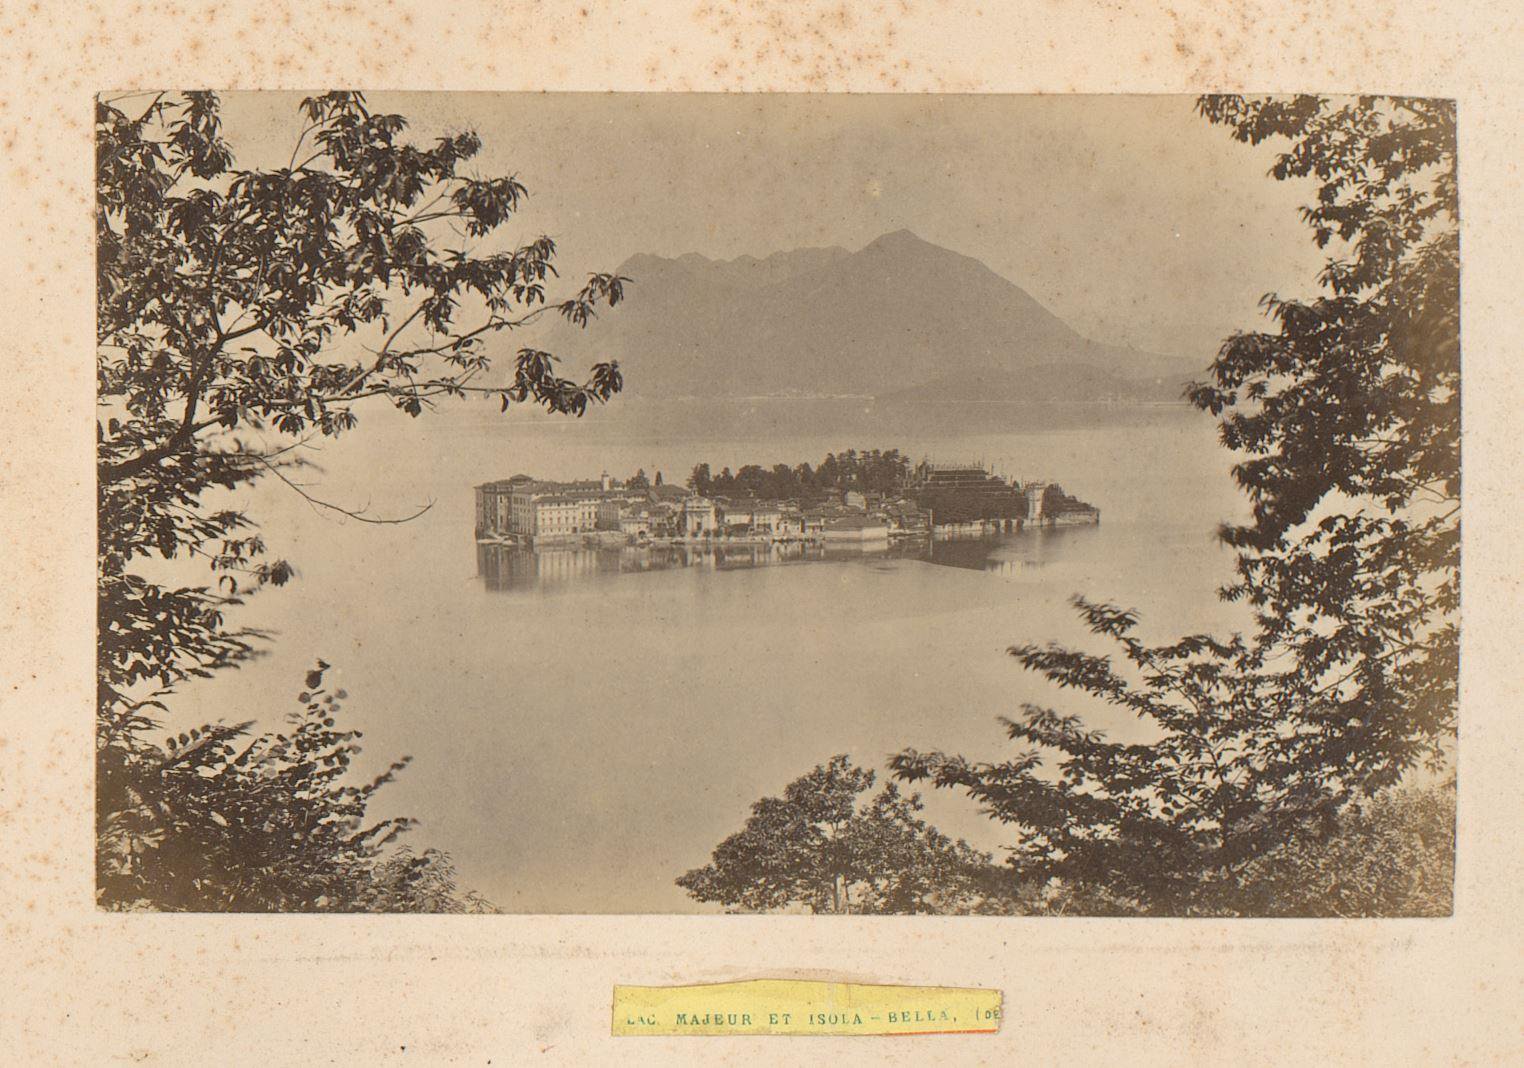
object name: photograph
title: Lac Majeur et Isola-Bella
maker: Anonymous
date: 1860-1890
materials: paper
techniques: albumen print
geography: lake maggiore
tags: island, lake, mountains